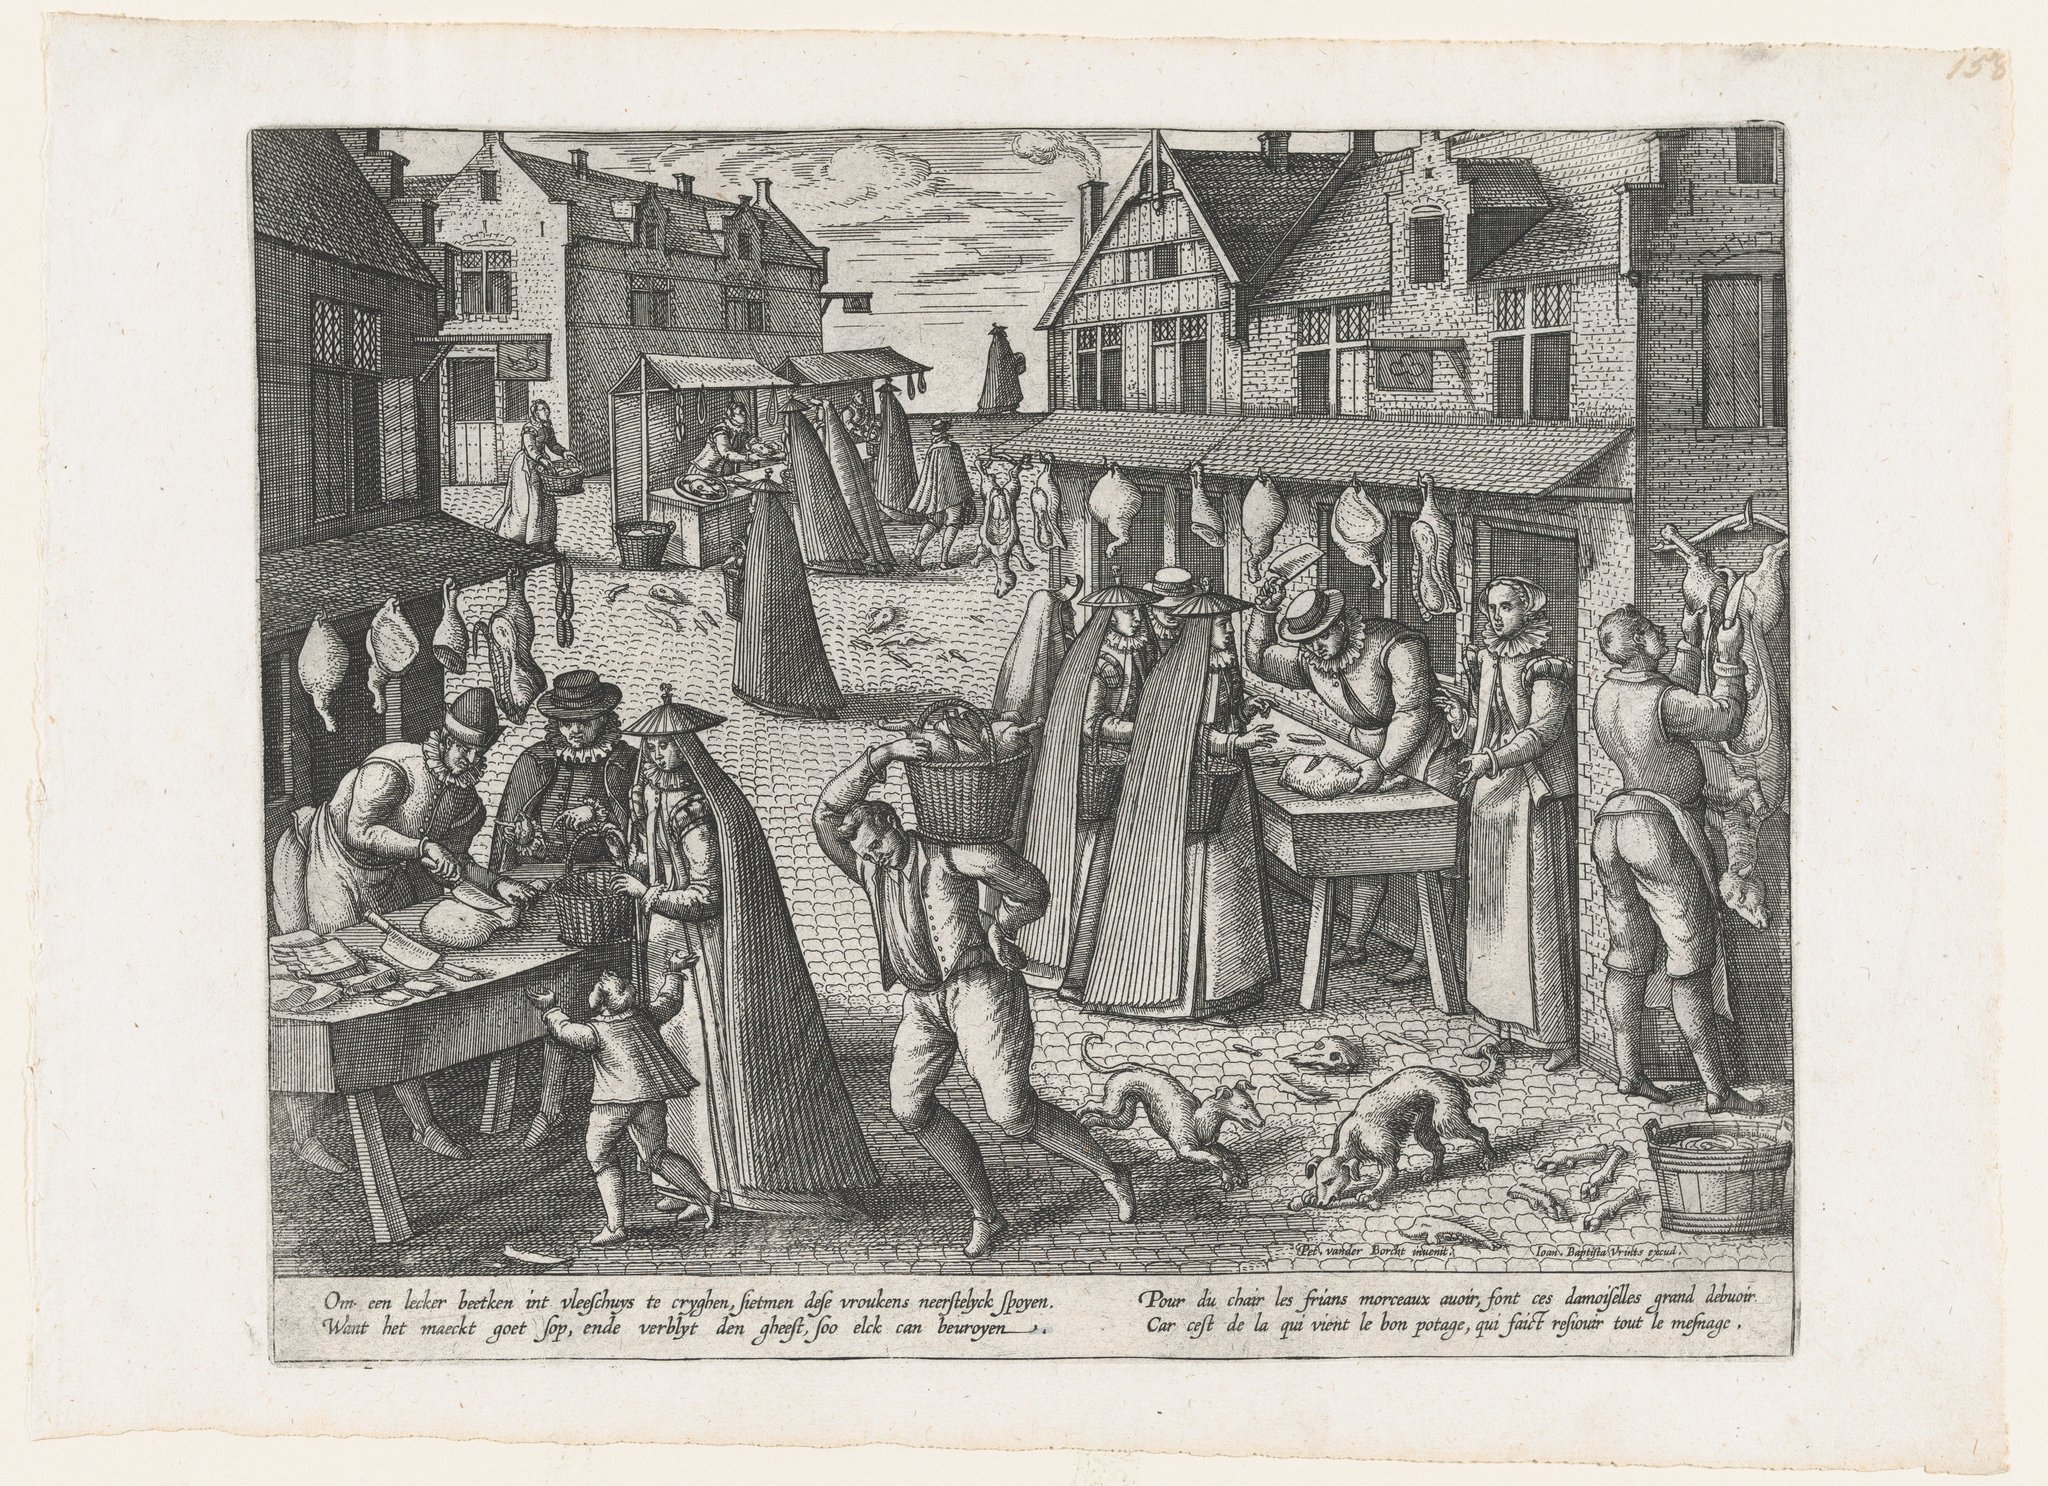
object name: print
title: Meat Market (from the pair Meat Market and Vegetable Market)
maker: peeter van der borcht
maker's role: artist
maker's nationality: netherlandish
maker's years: 1530-1608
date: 1575-1608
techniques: etching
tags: houses,men,women,dogs,markets